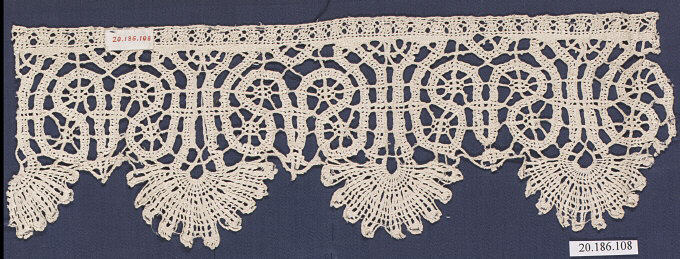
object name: edging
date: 1601-1700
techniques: lace